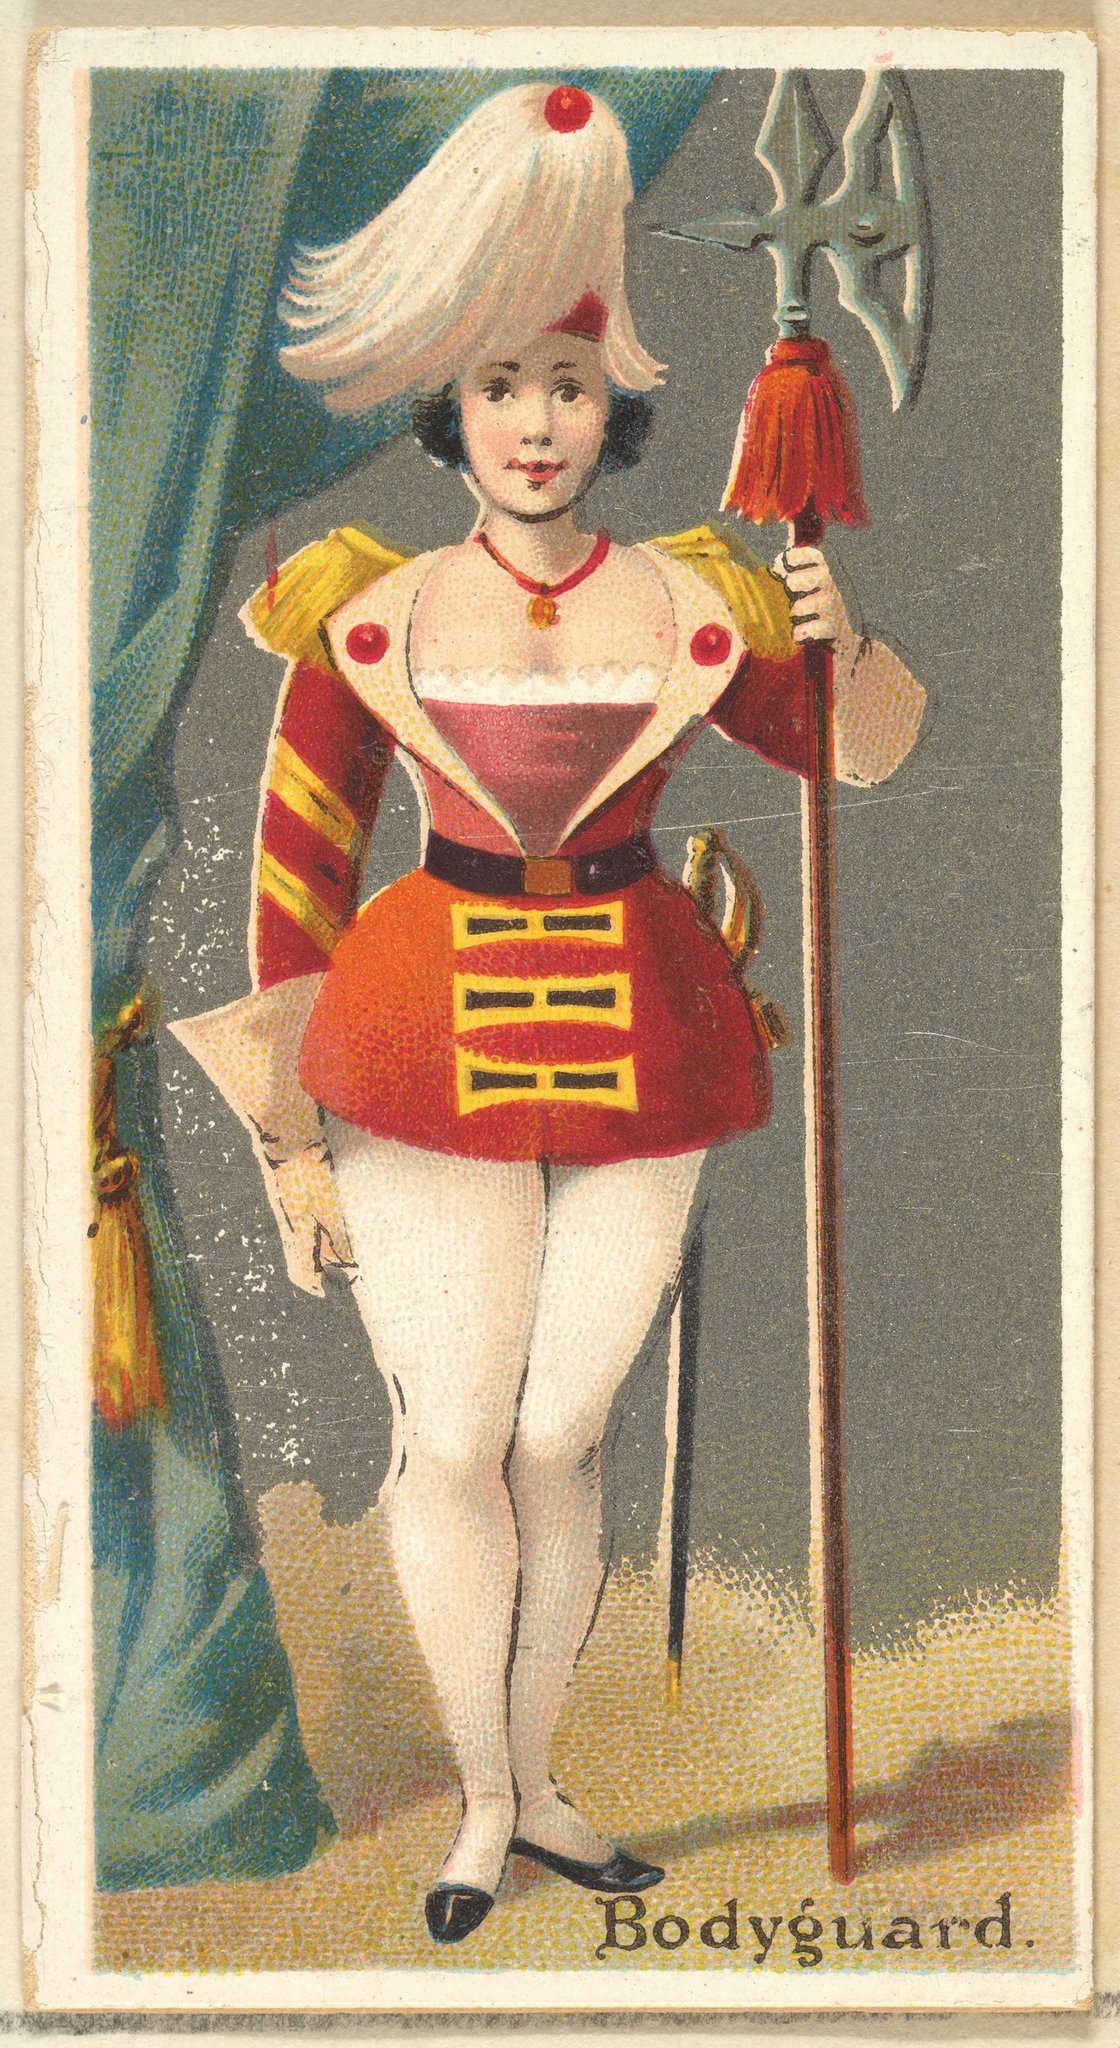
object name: print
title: Bodyguard, from the Occupations for Women series (N166) for Old Judge and Dogs Head Cigarettes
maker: goodwin & company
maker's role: publisher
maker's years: 1850-1950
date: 1887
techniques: color lithograph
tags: women